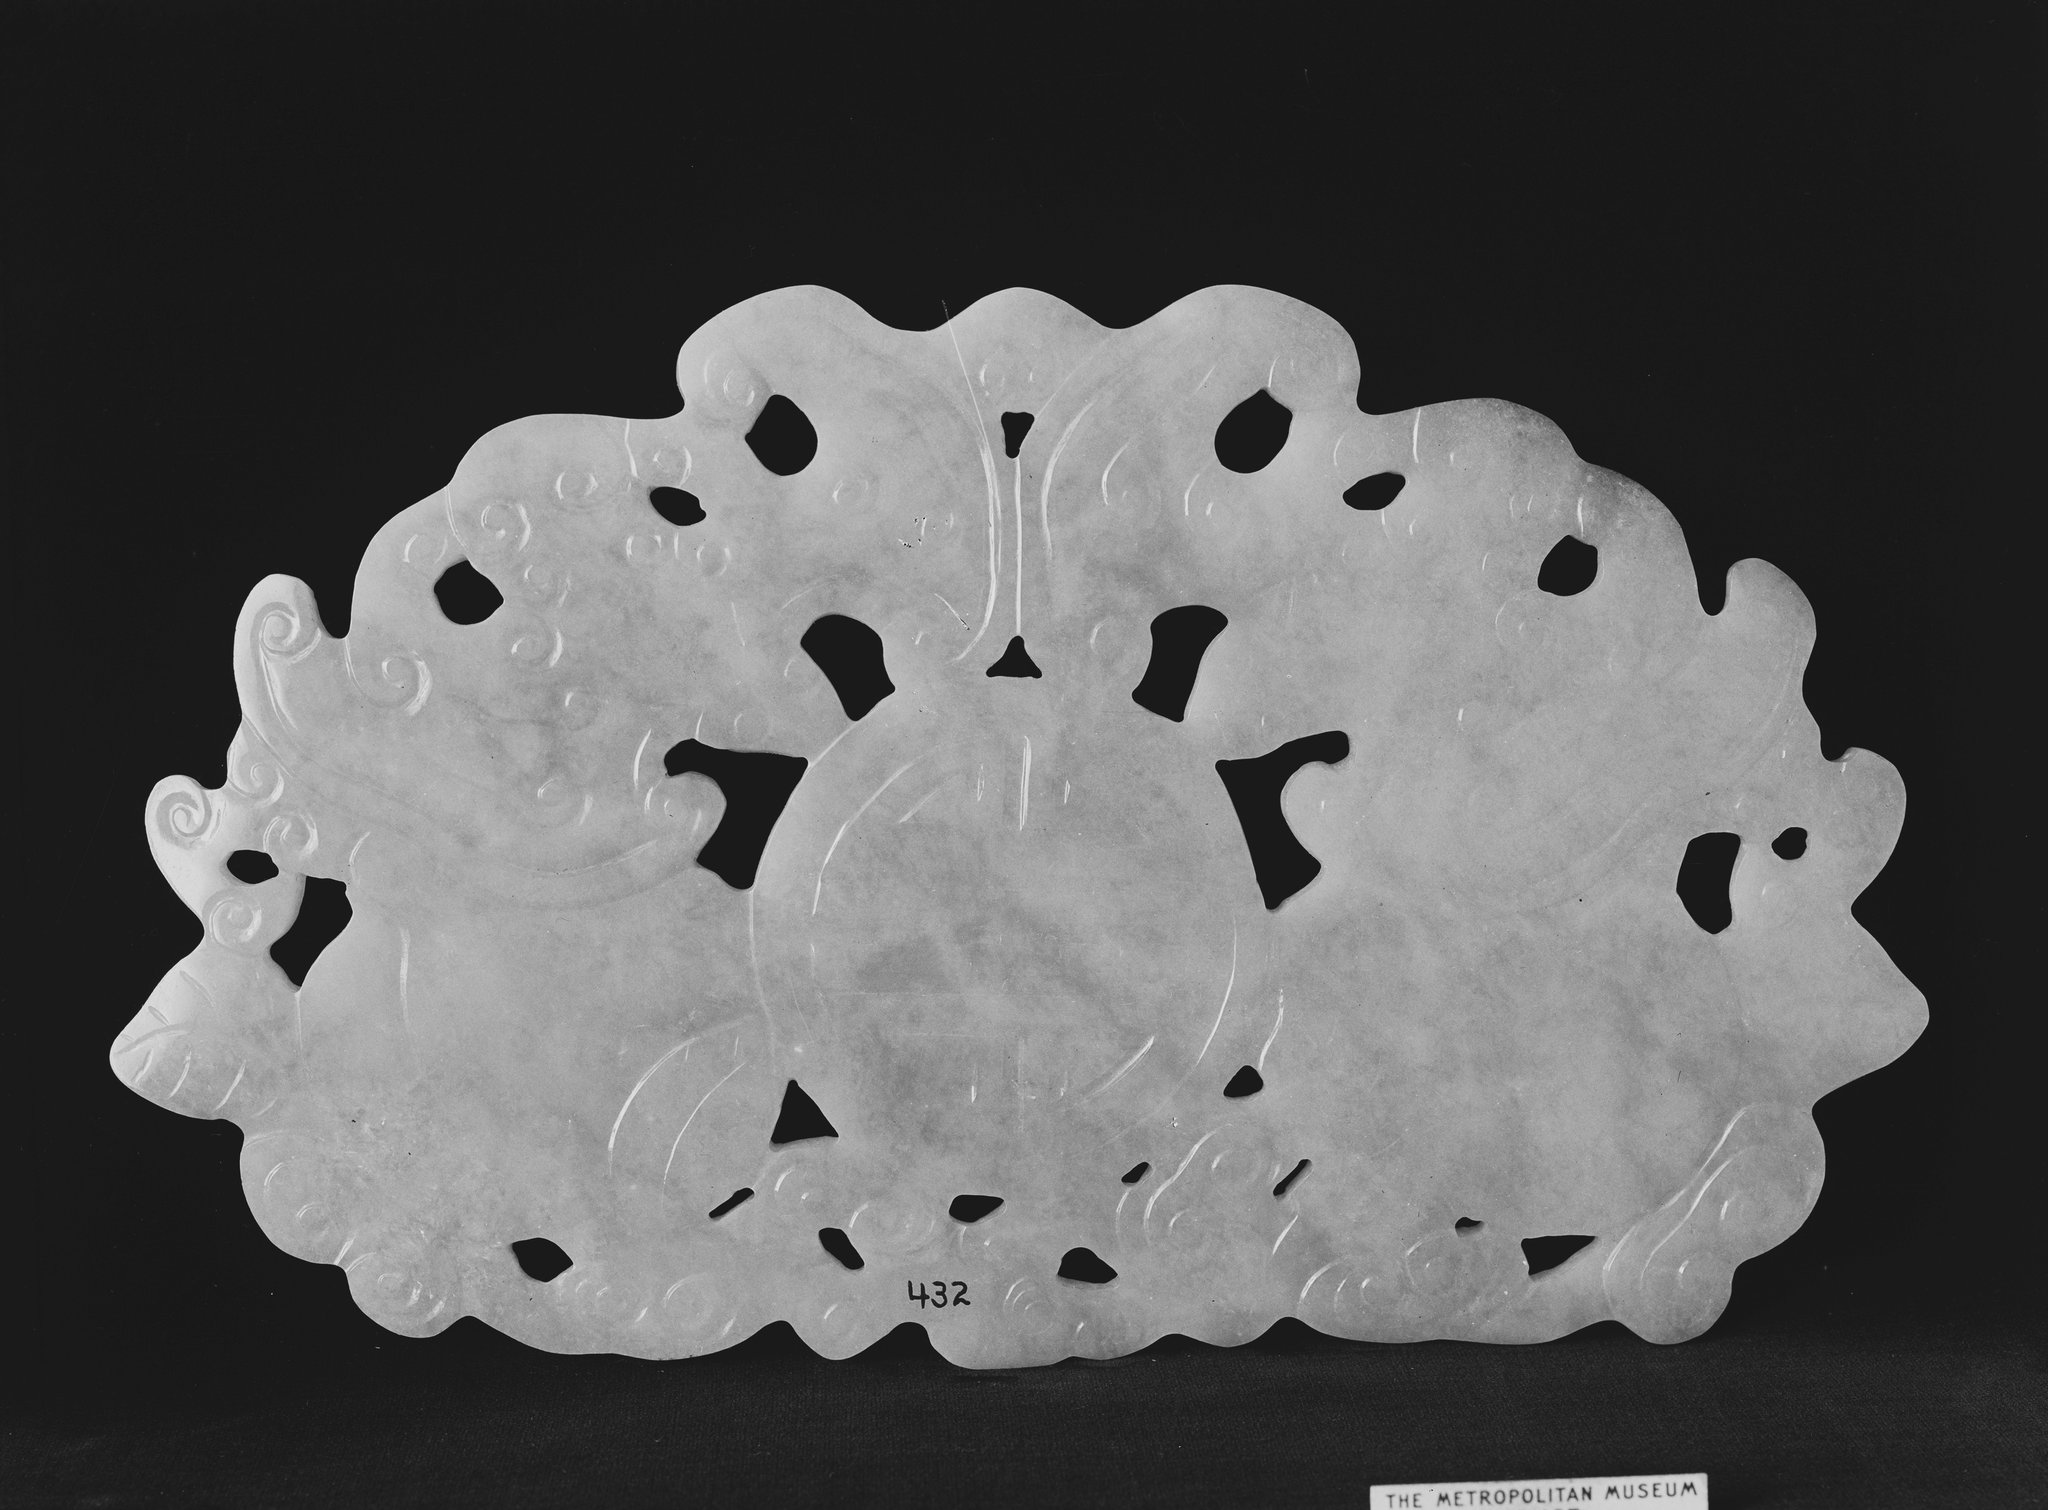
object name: hanging gong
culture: chinese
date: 1662-1722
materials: gemstone, jade